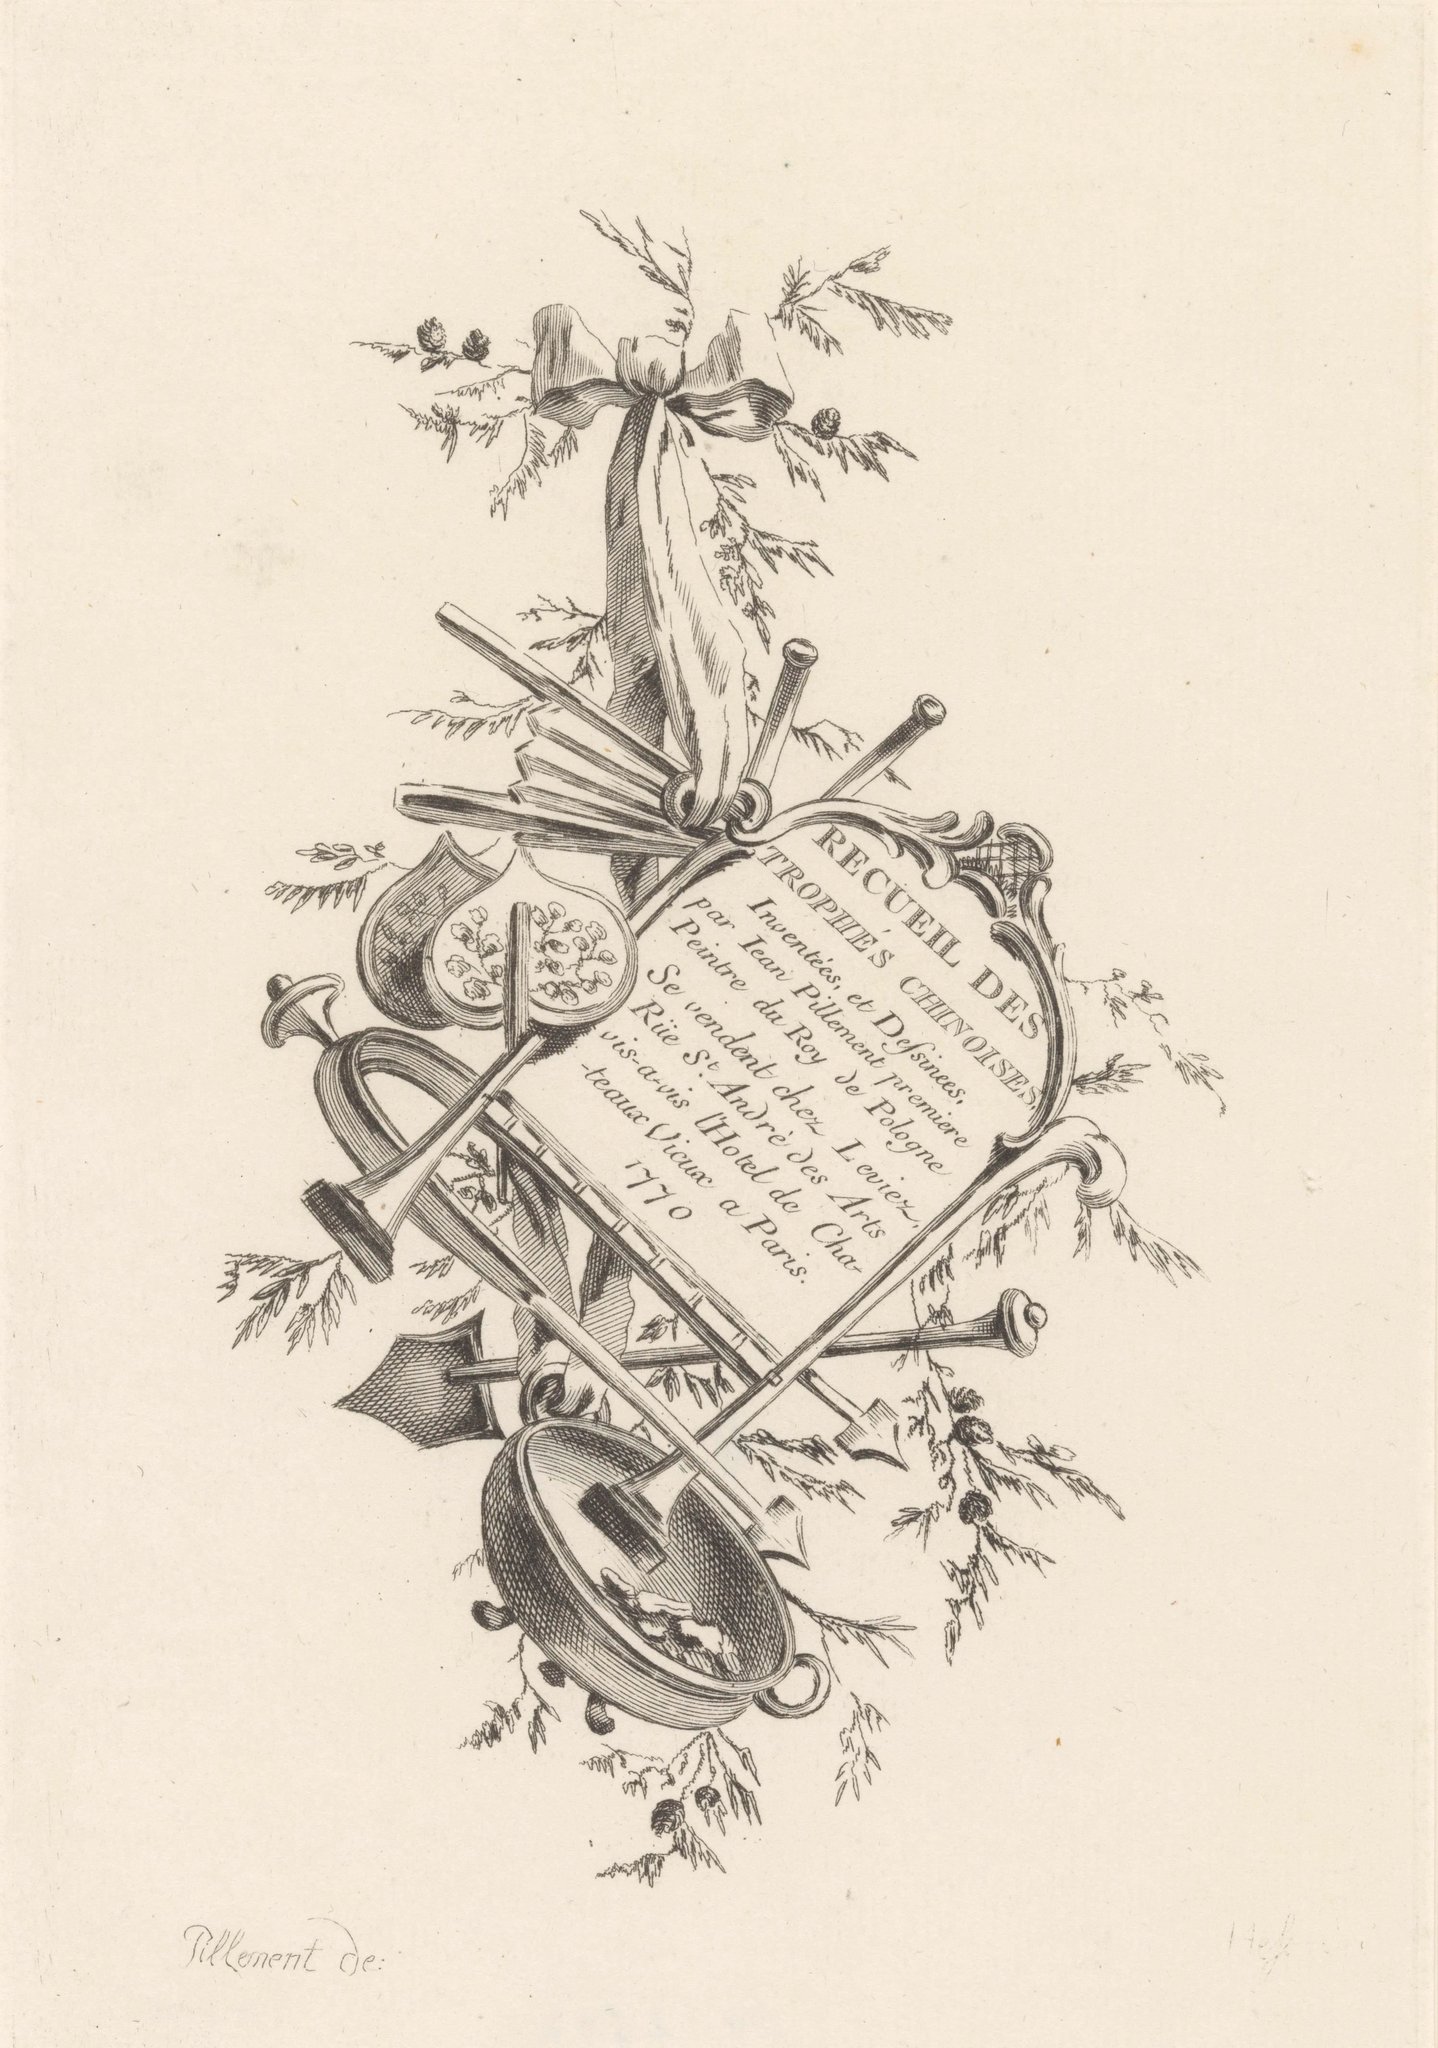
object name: print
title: Recueil Des Trophés Chinoises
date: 1770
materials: paper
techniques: etching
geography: paris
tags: trophy, i.e.: decorative arrangement of symbolic or typical objects ~ ornament, fire-tongs, kitchen-utensils (with name), bellows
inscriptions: collector's mark: Lugt 2760, collector's mark: Lugt 2228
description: Een trofee met een blaasbalg, een tang, een schep, een ketel met kolen en een standaard waarop de serietitel.